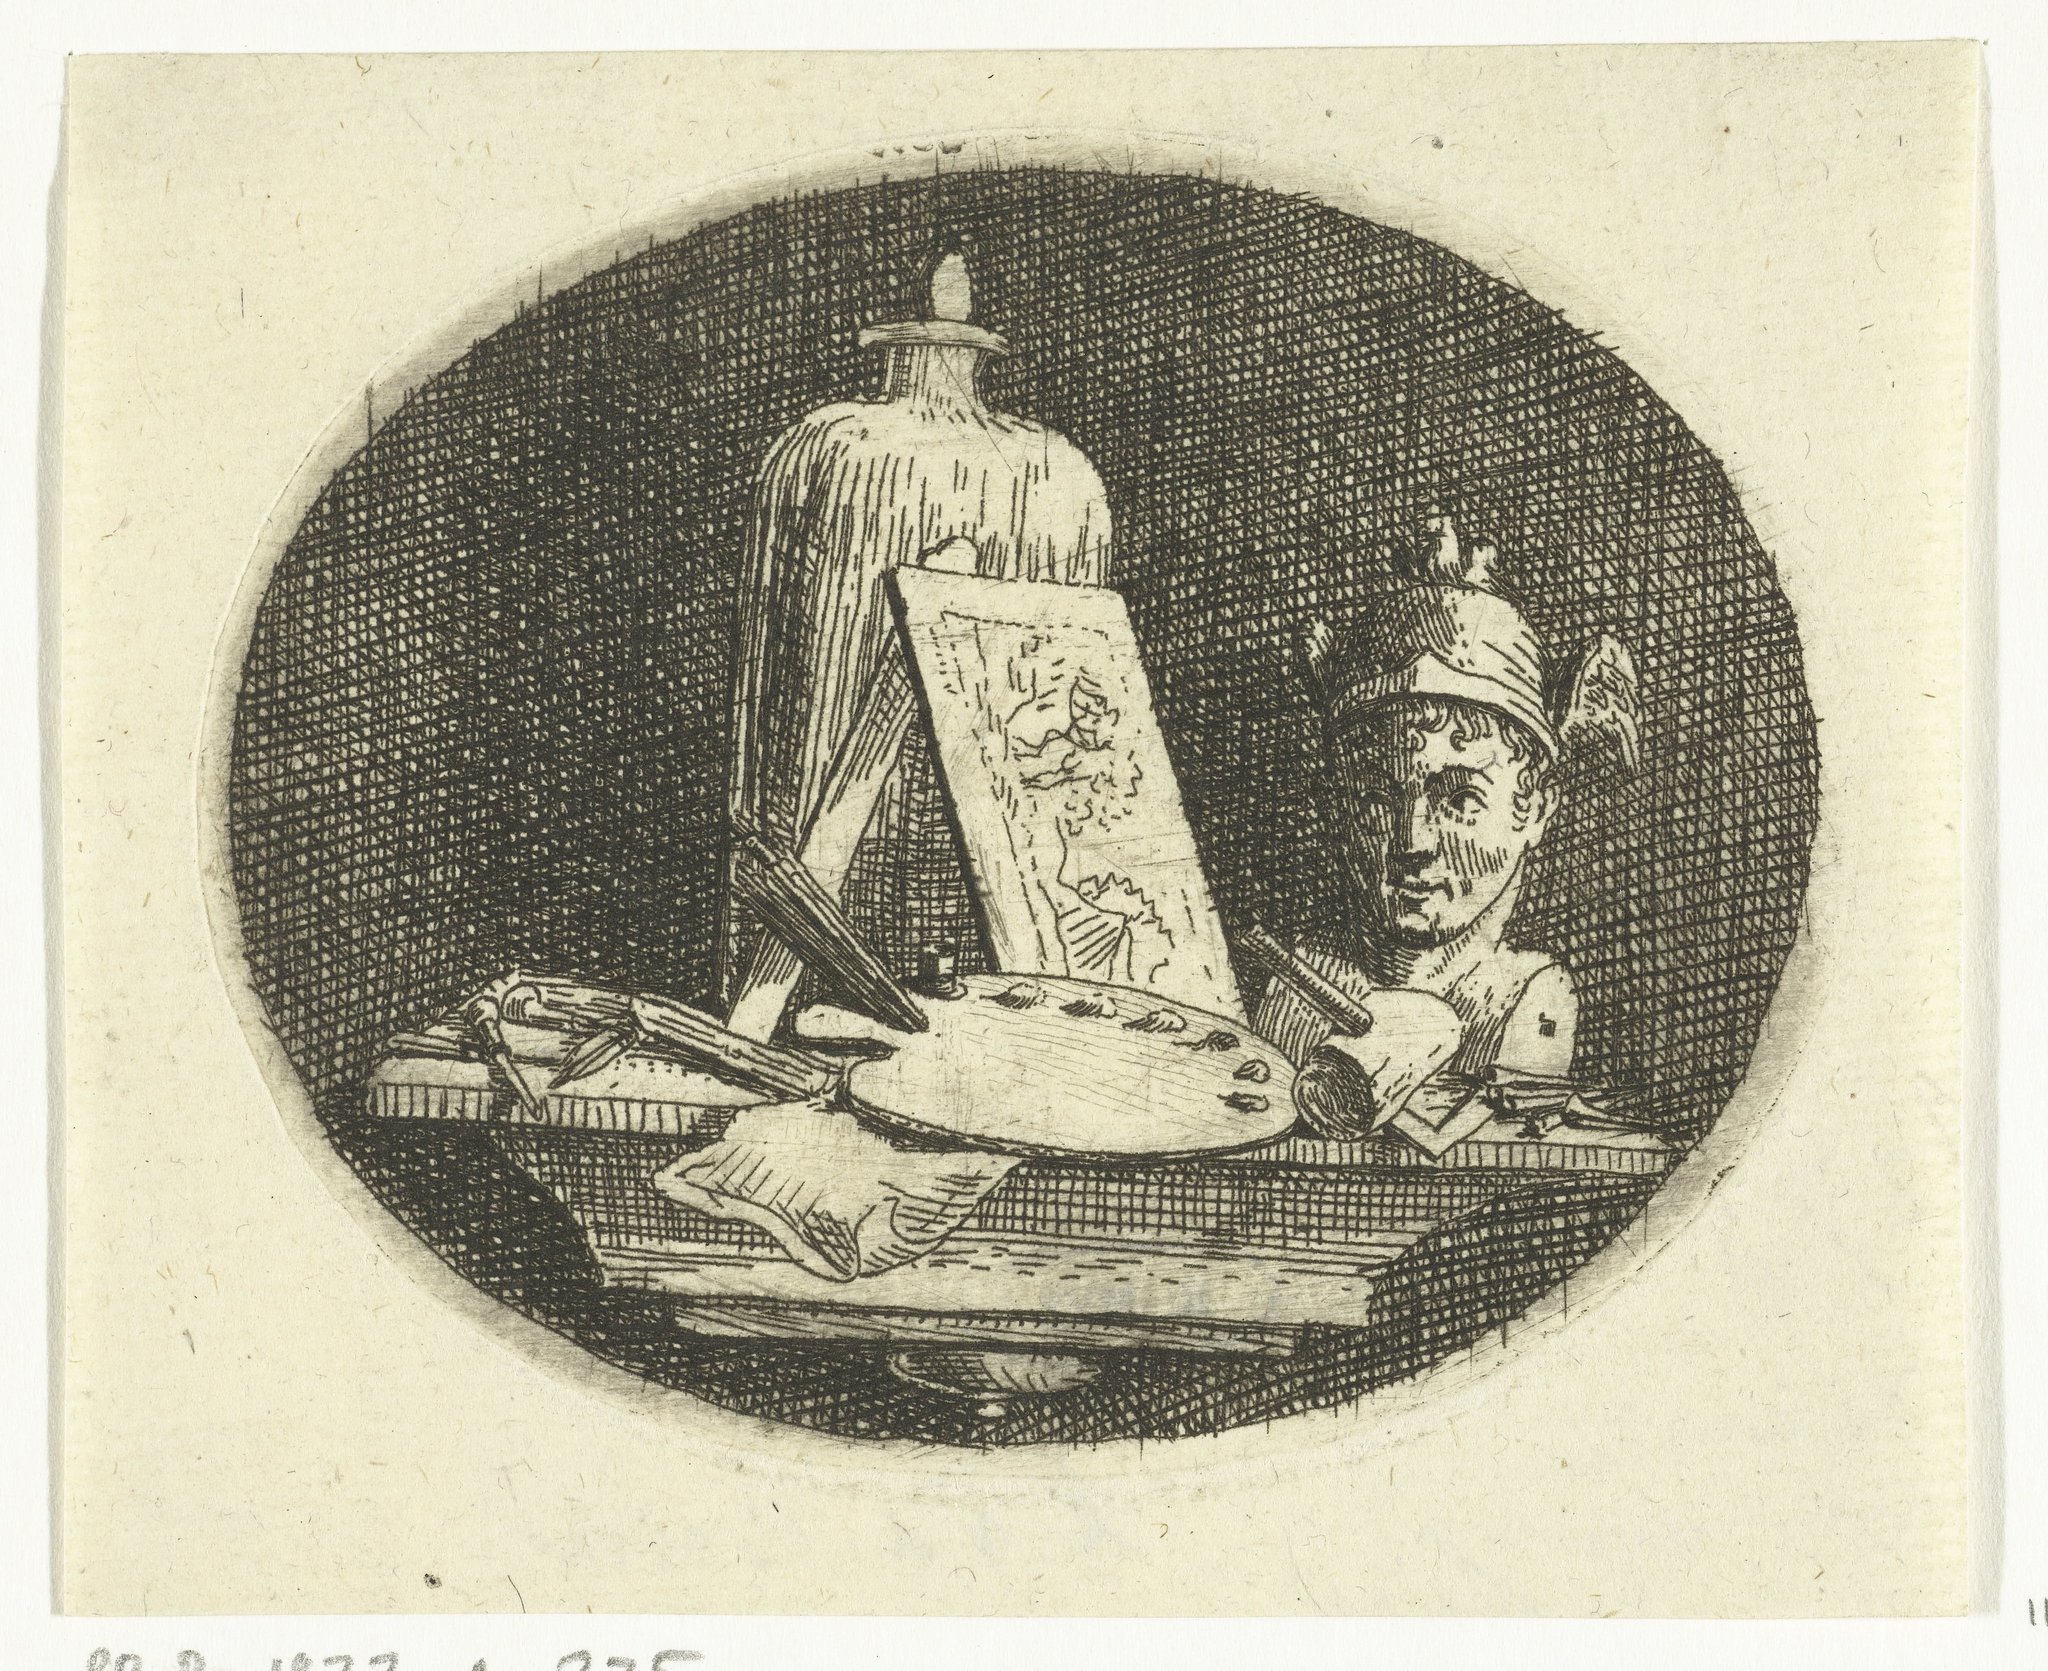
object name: print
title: Stilleven met palet, schilderij en buste van Mercurius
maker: anthonie van den bos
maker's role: draughtsman, print maker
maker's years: 1763-1838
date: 1778-1838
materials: paper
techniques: etching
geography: netherlands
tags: (story of) mercury (hermes), still life of related objects, tools, implements of painter, palette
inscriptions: collector's mark: Lugt 2228